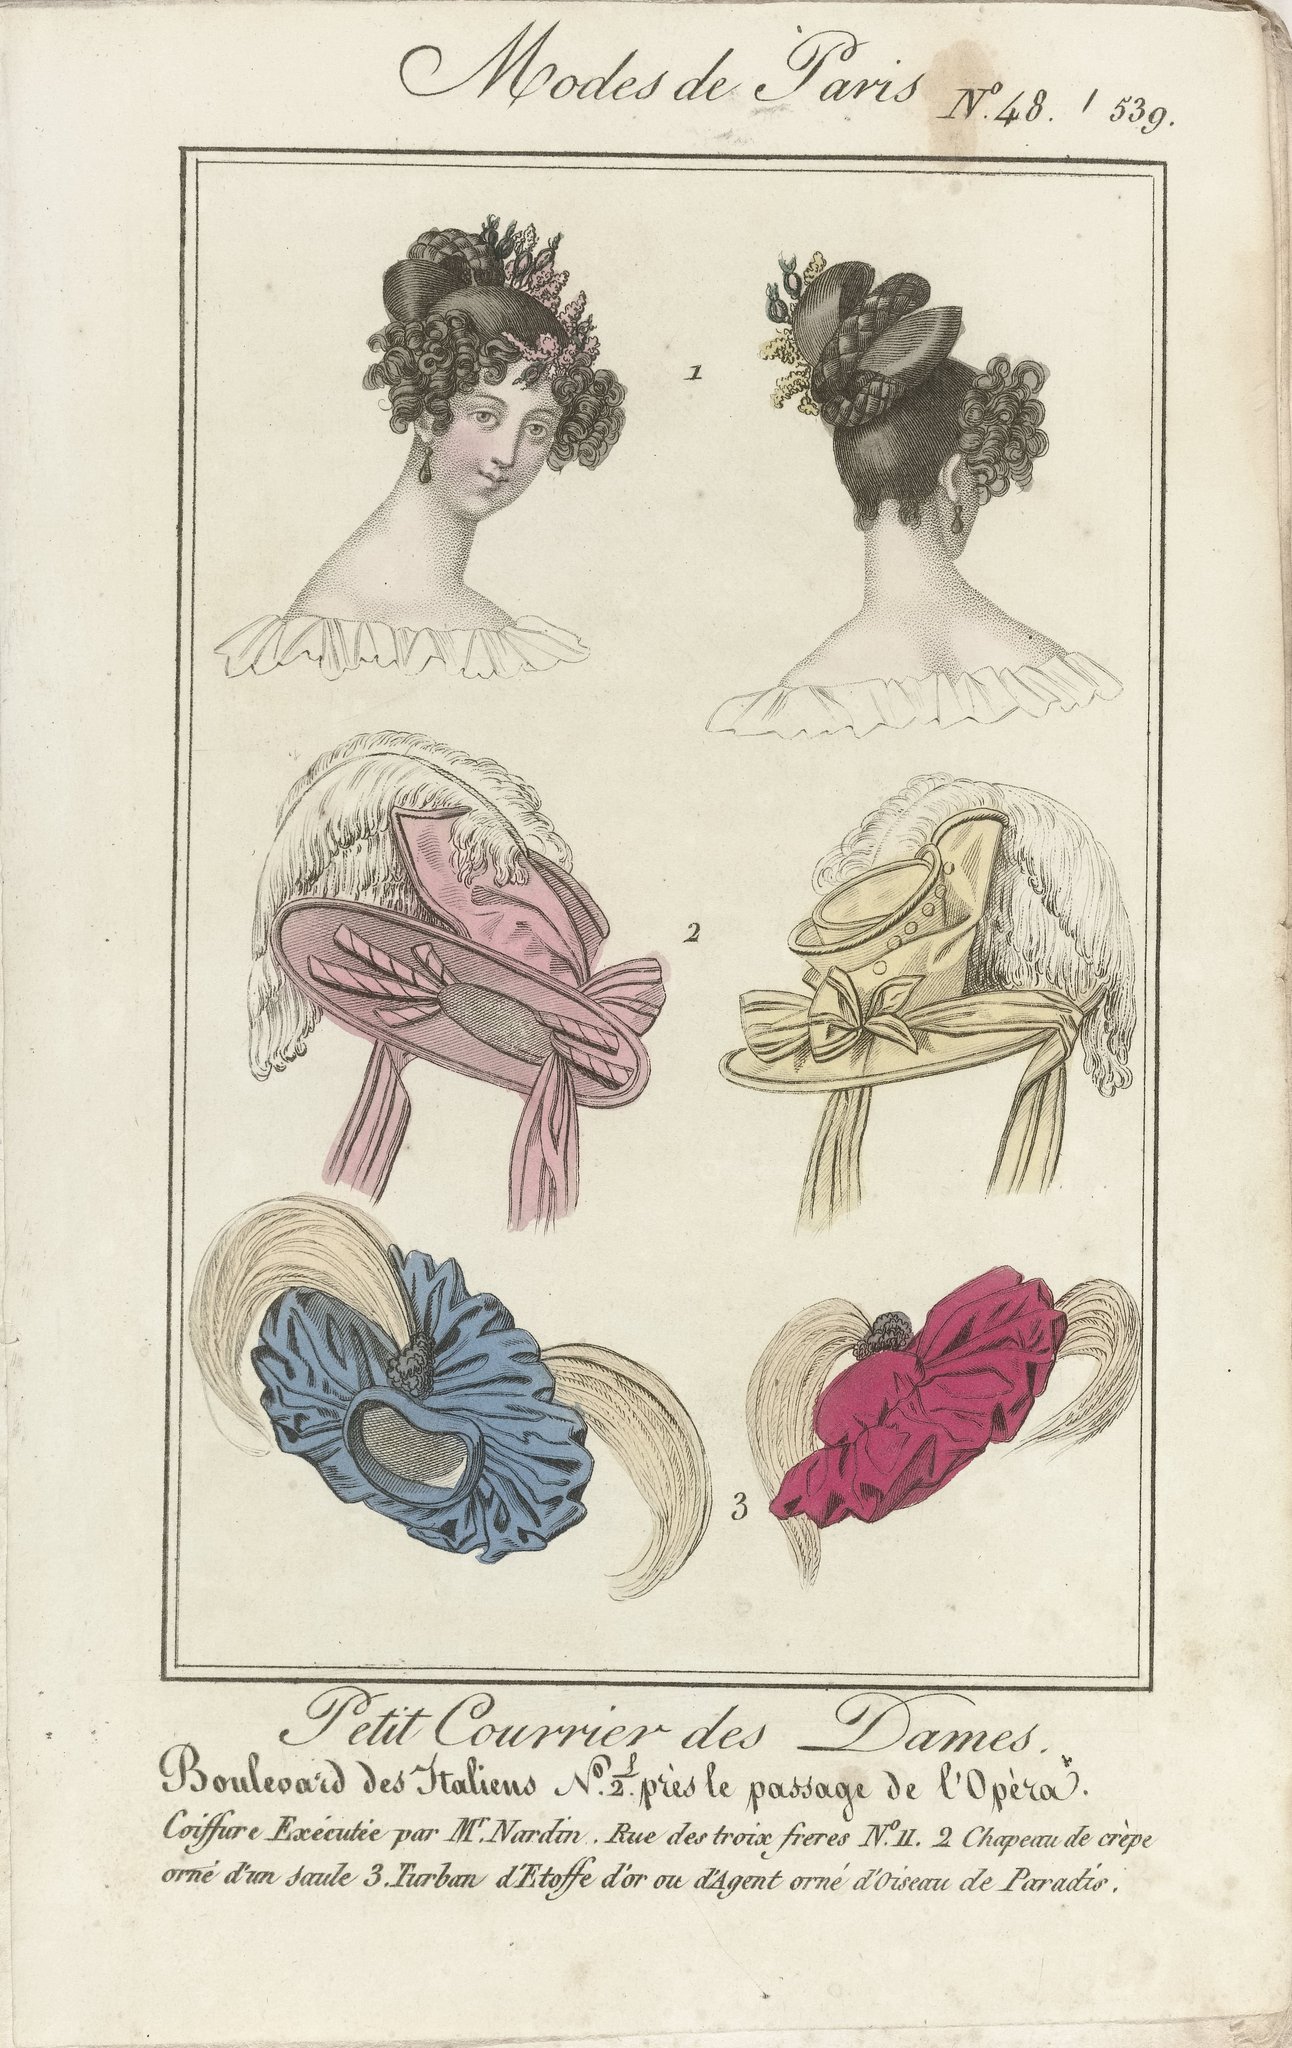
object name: magazine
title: Petit Courrier des Dames, 1828 No. 48 (539)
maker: Anonymous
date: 1828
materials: paper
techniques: engraving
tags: fashion plates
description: Prent uit het modetijdschrift Petit Courrier des Dames (1821-1868).